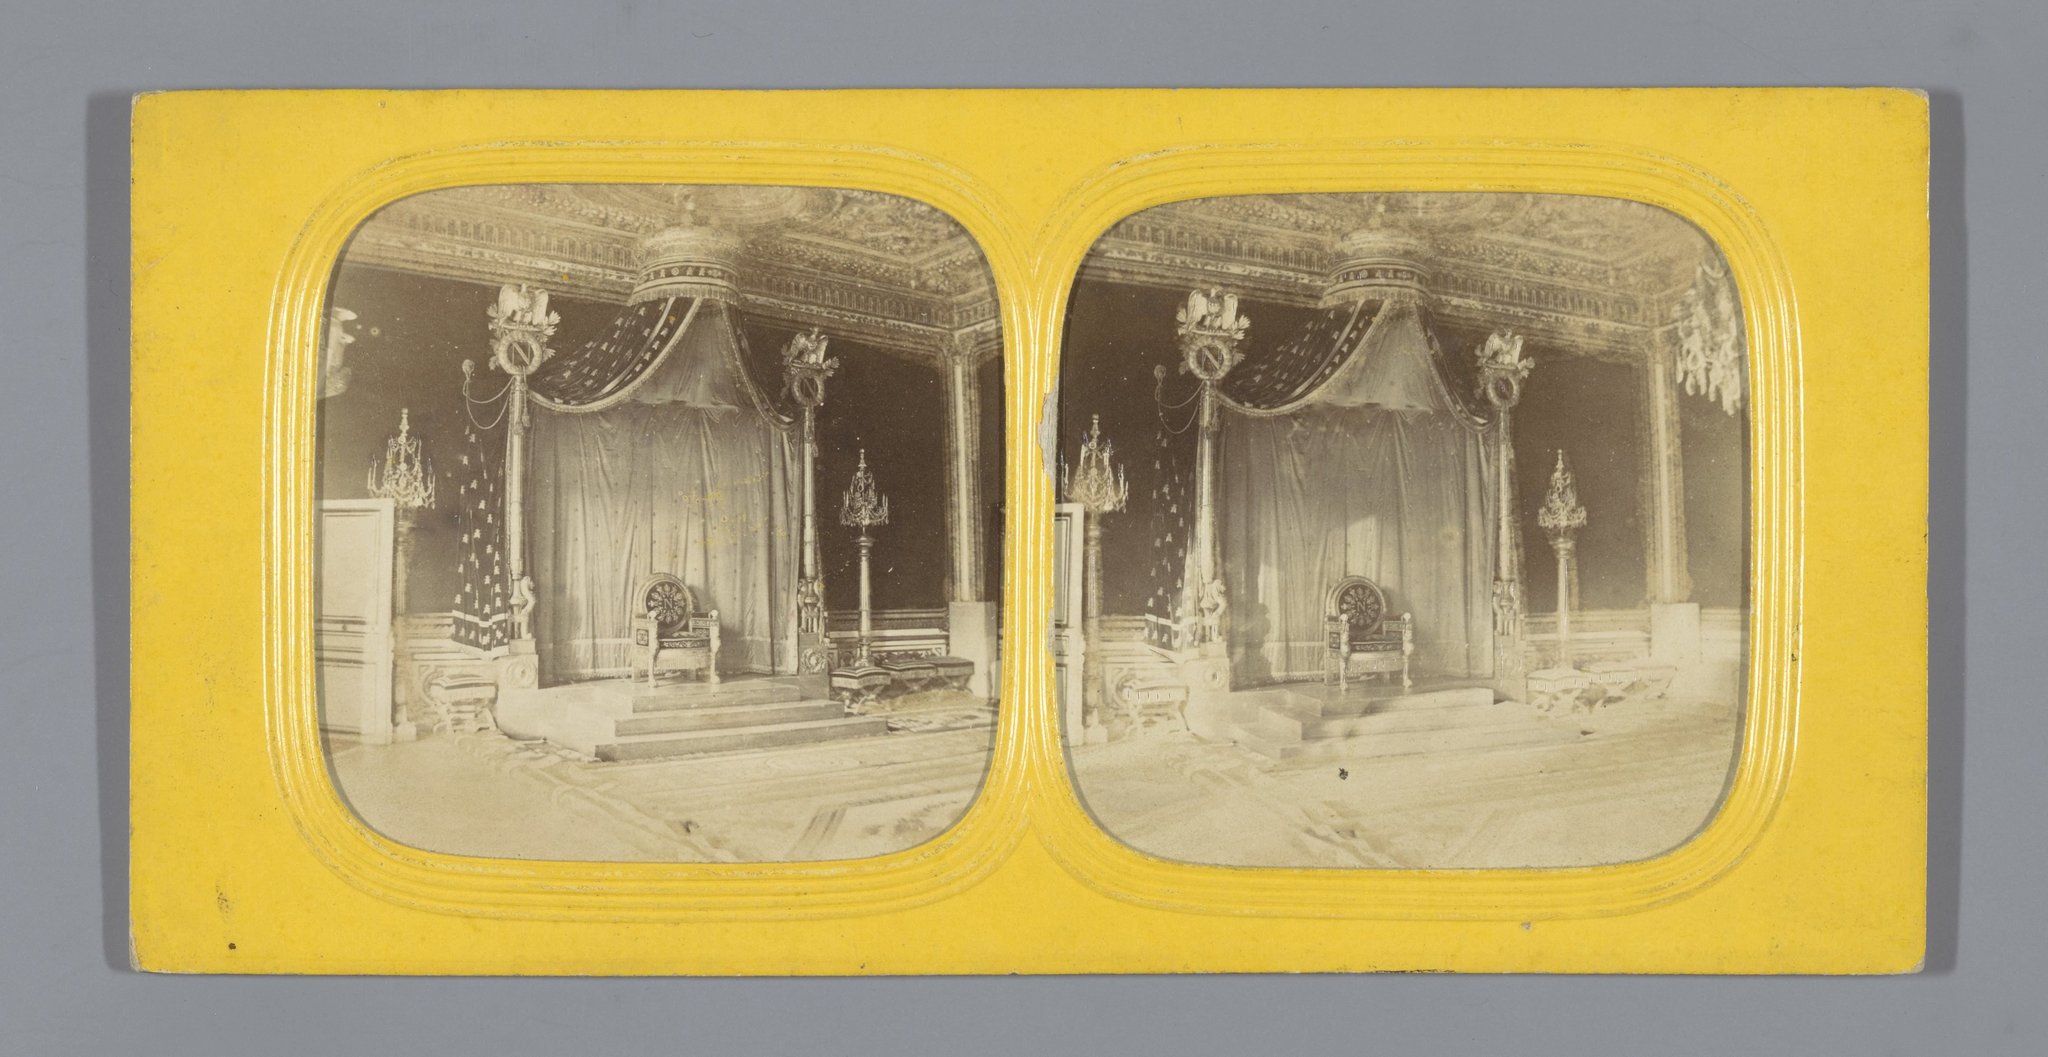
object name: tissue stereograph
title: Troonzaal in het kasteel van Fontainebleau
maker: charles gaudin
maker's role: publisher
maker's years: 1825-1905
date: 1858-1875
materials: cardboard, paper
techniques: albumen print, hand coloring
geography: fontainebleau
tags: throne-room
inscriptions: inscription: ‘Parijs’